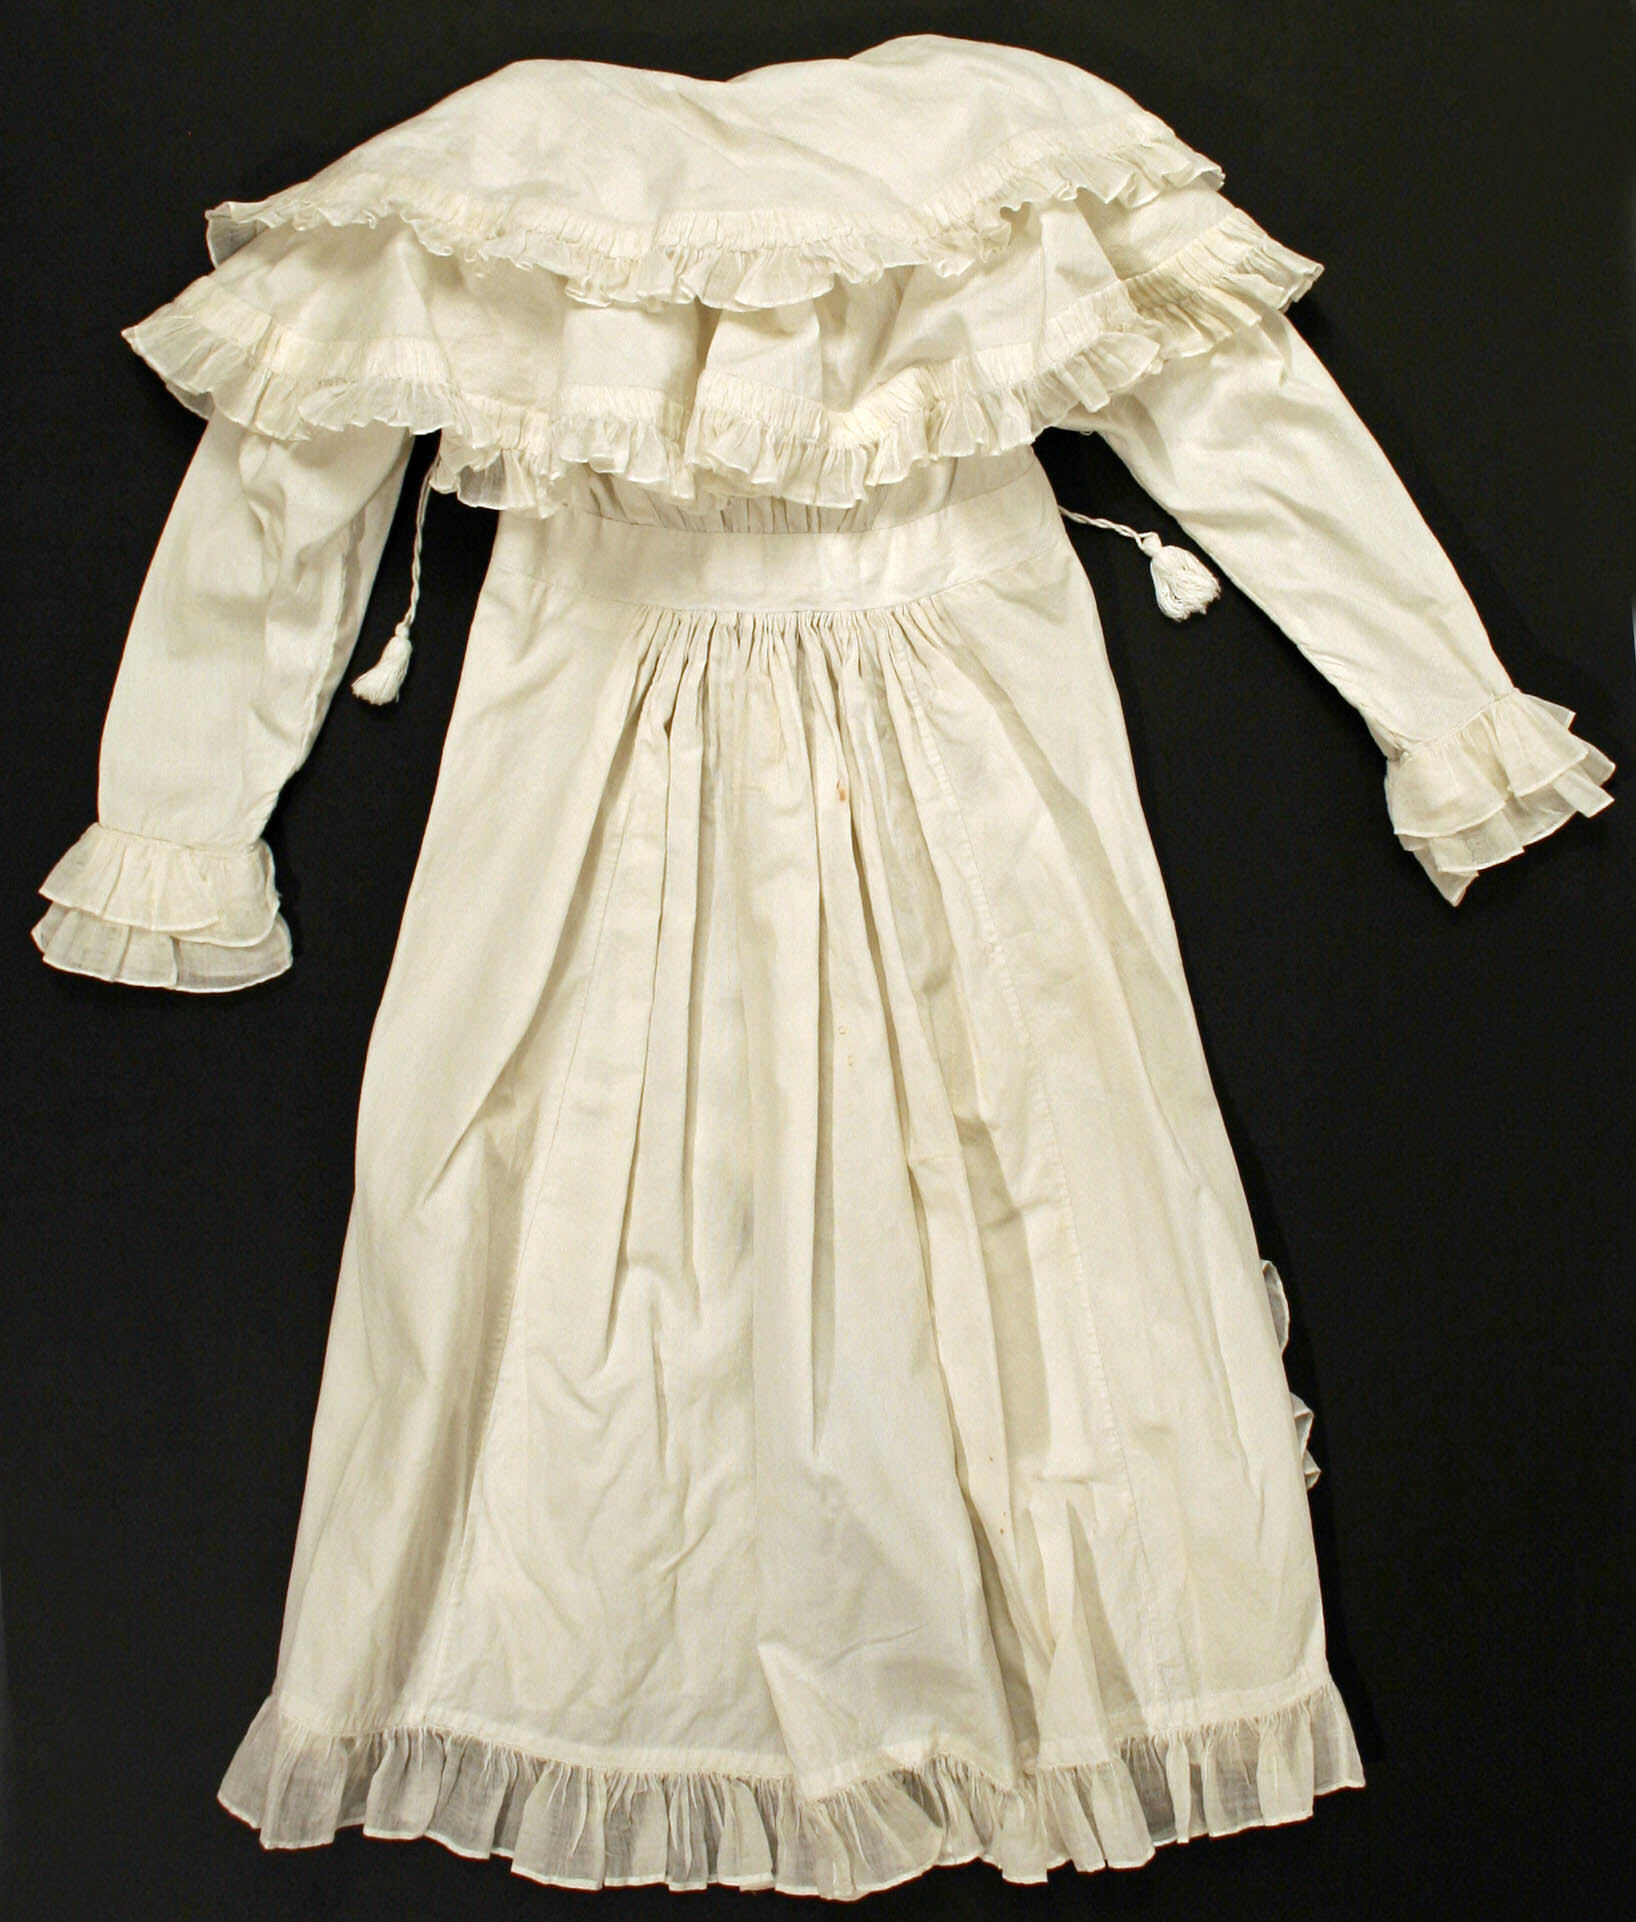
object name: pelisse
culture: british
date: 1817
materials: cotton